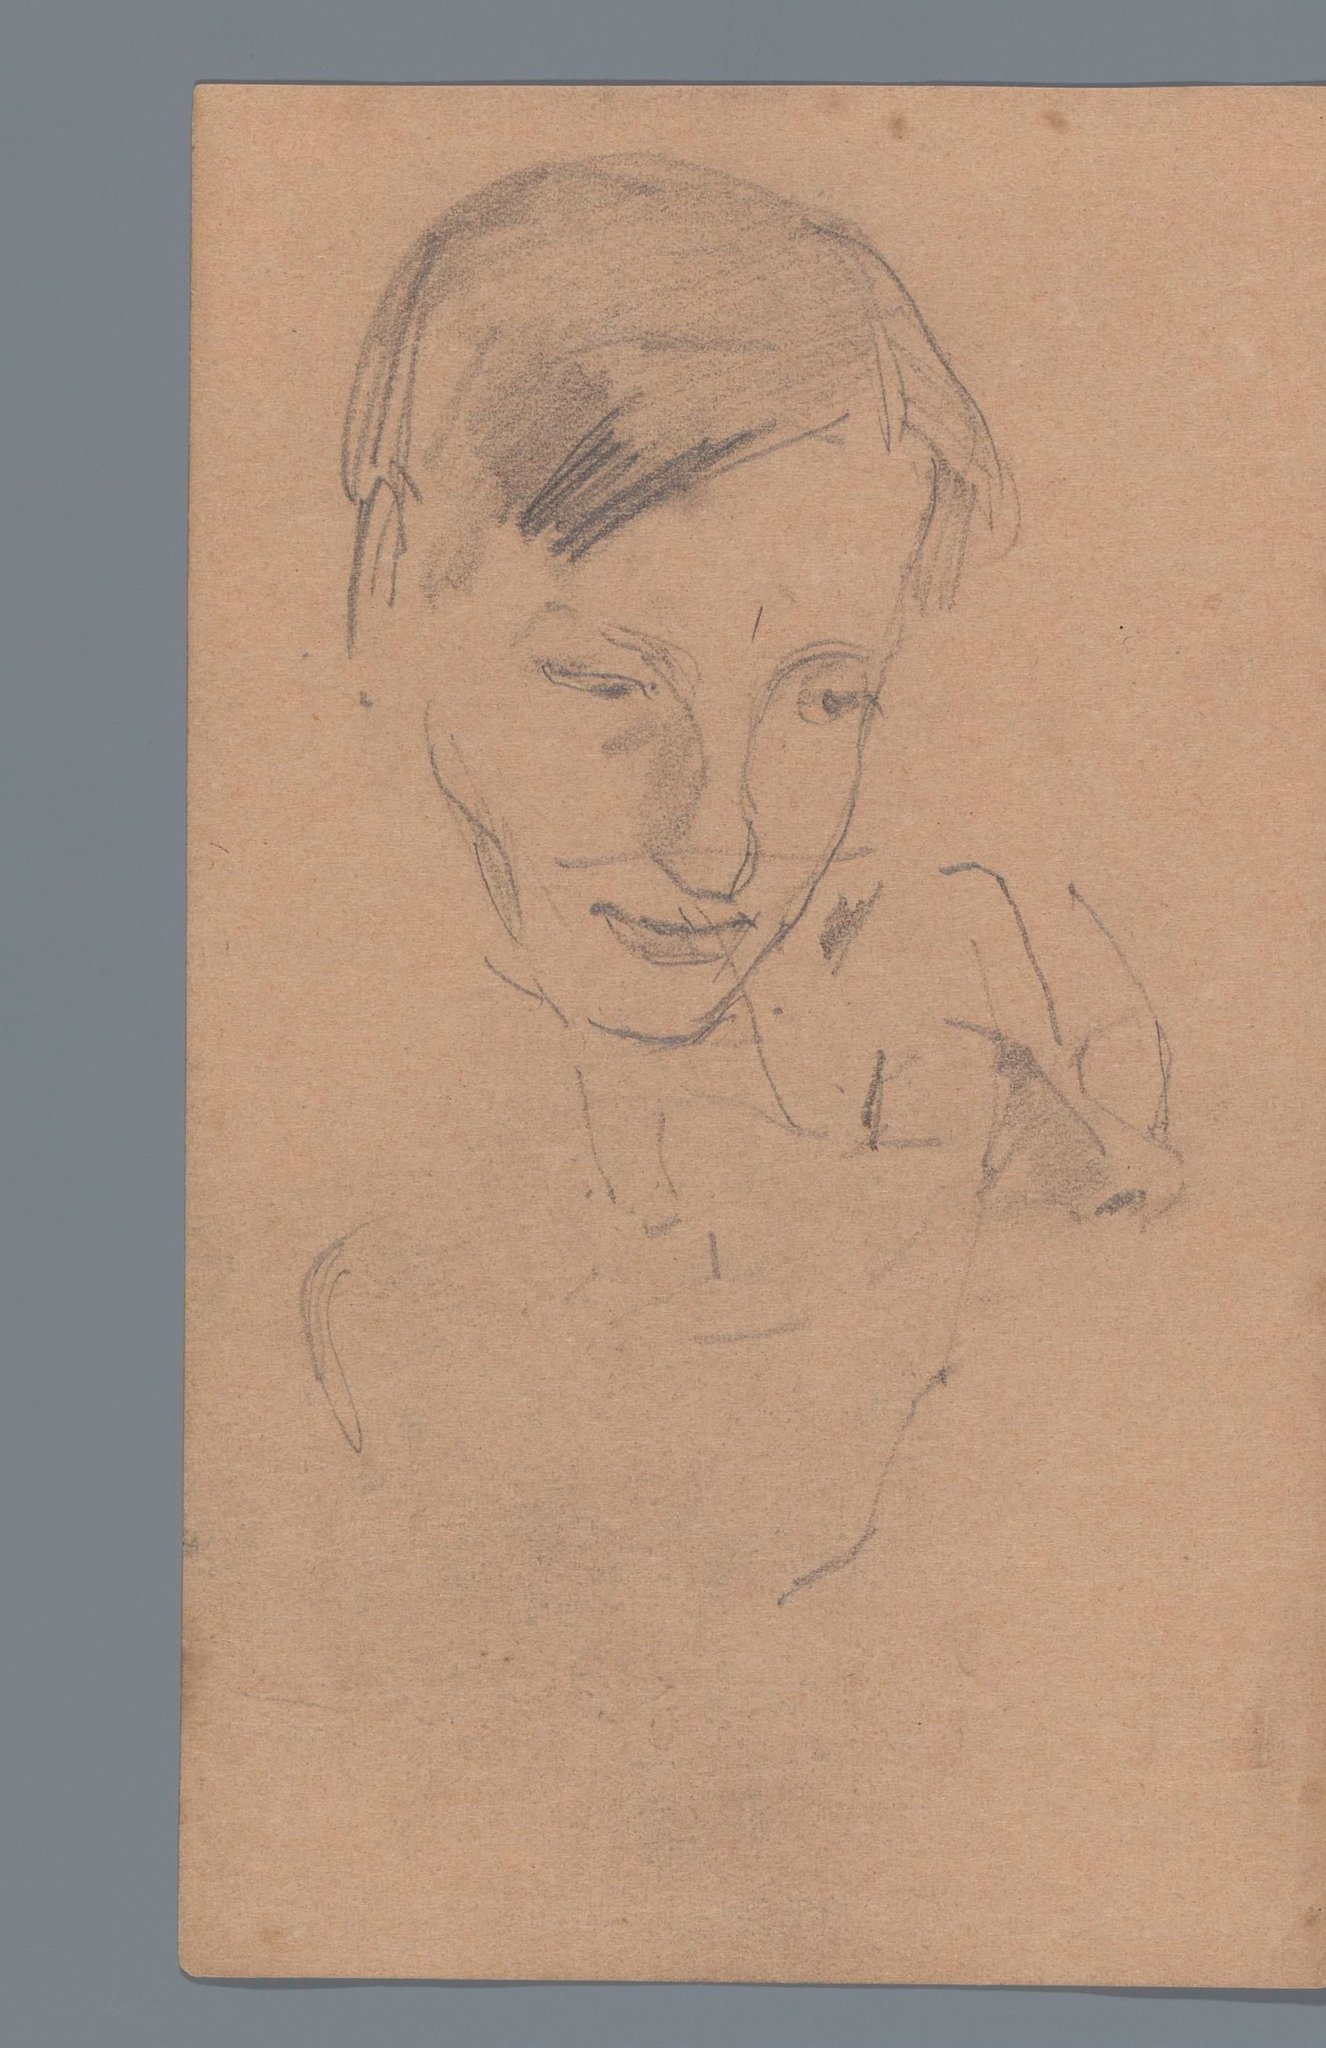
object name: drawing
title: Hoofd van een jonge man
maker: george hendrik breitner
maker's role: draughtsman, painter, print maker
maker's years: 1857-1923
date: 1880-1882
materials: paper, pencil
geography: rotterdam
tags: head (human), youth, adolescent